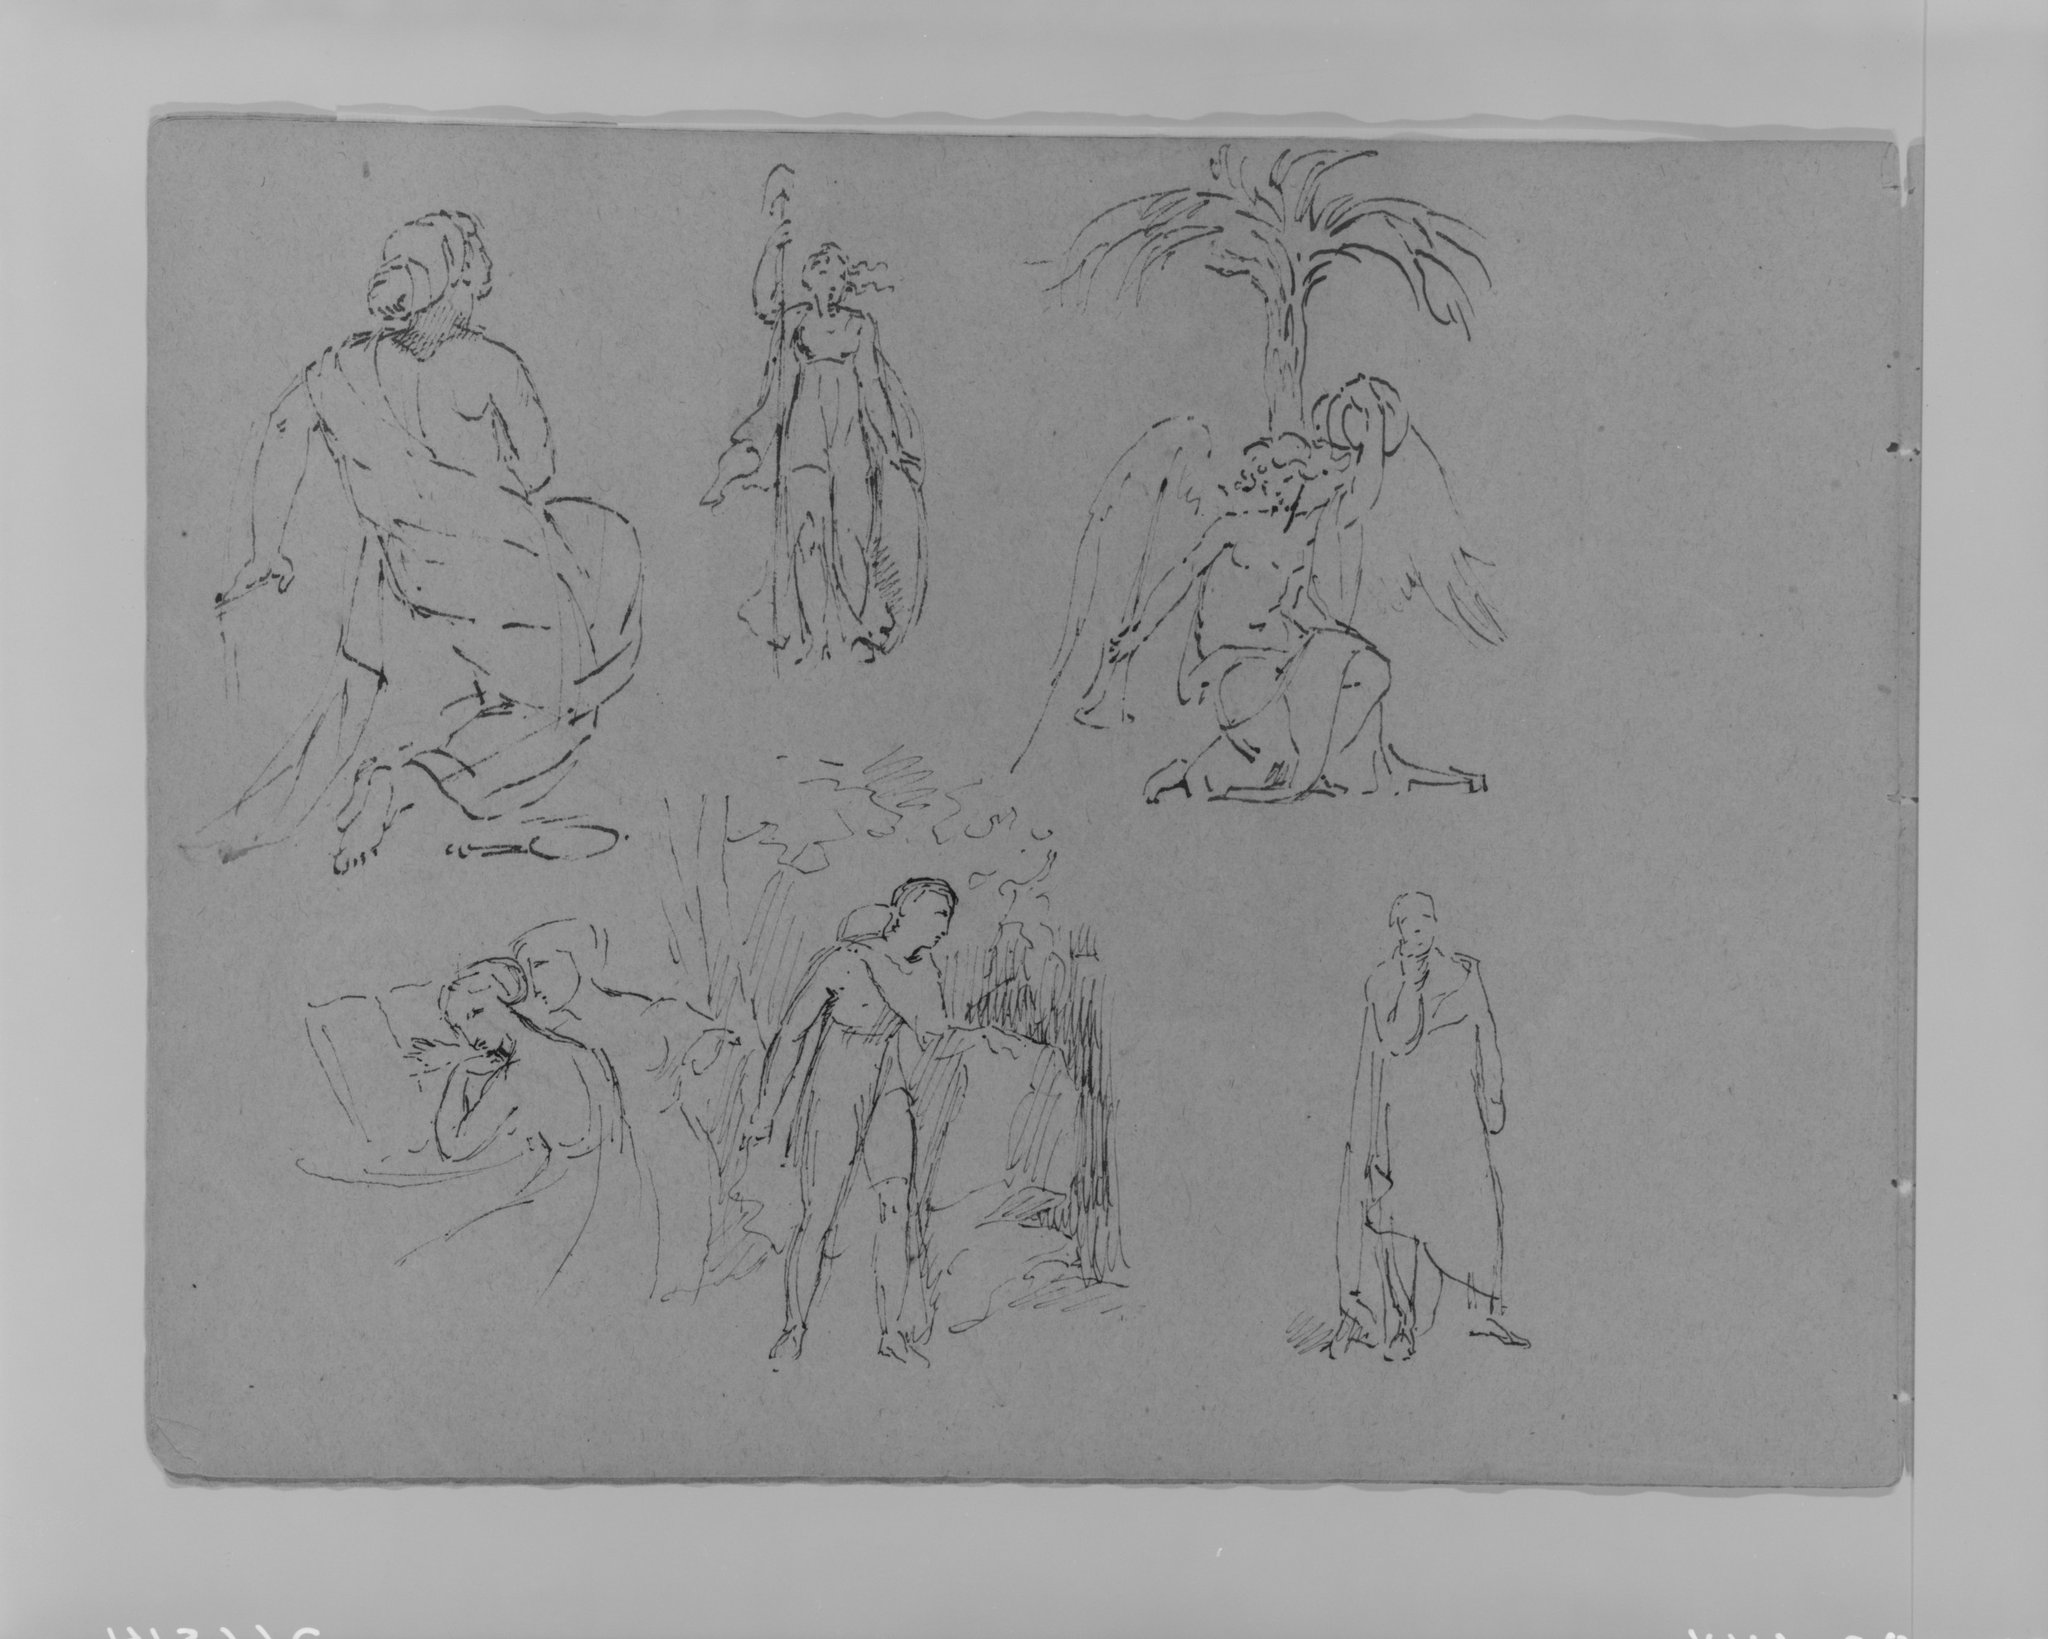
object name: drawing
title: Six Figure Studies, Including an Angel Seated Beneath Palm Tree (from Sketchbook)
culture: american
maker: thomas sully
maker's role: artist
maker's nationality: american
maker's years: 1783-1872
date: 1810-1820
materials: ink, paper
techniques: wash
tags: men,women,palms,angels